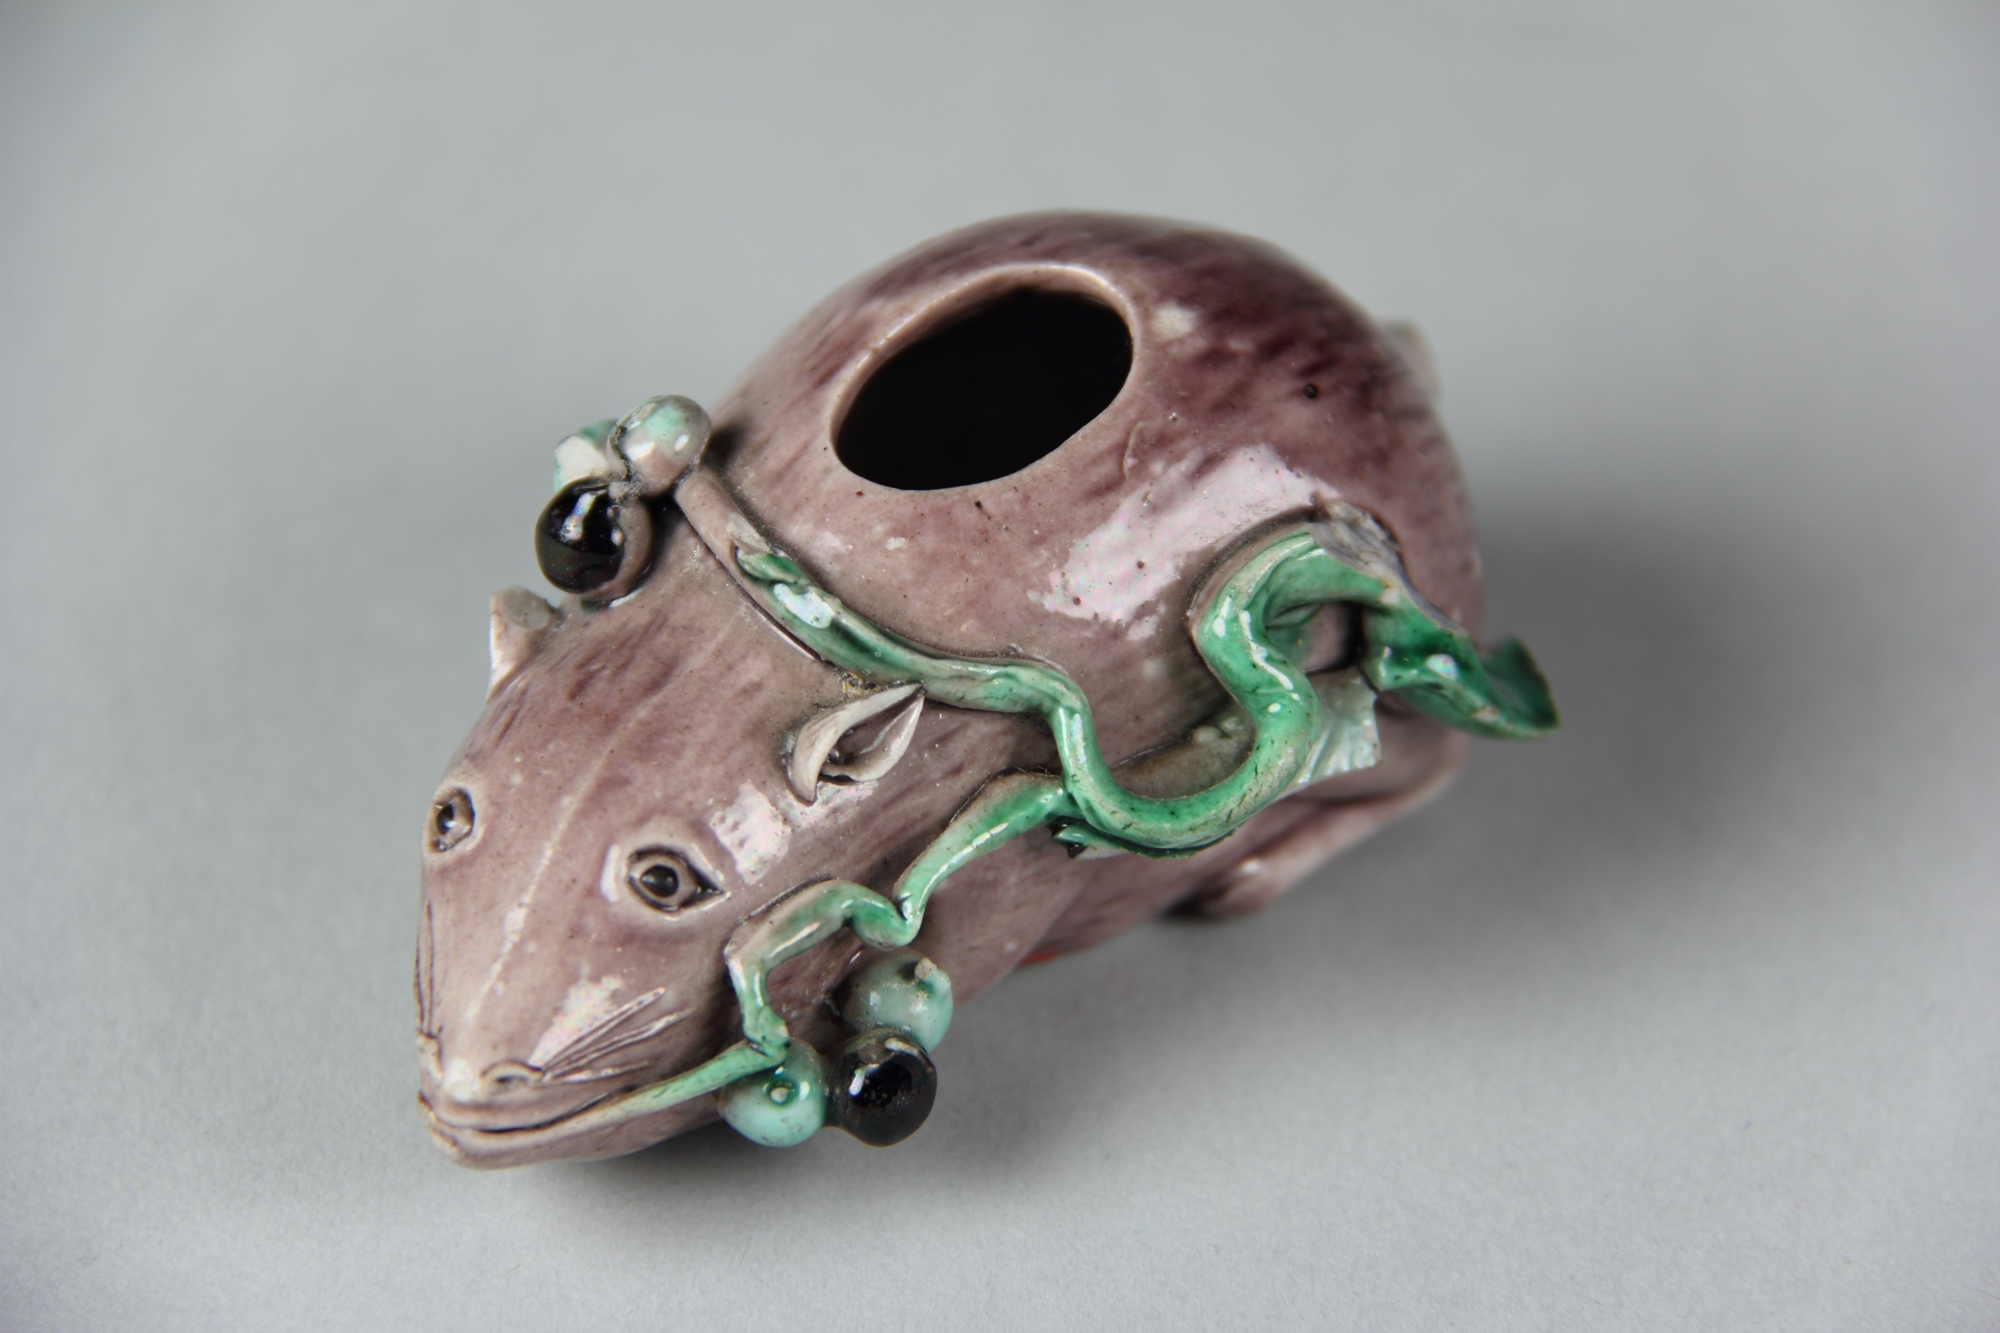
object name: water coupe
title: Water Coupe in the Shape of a Mouse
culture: chinese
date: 1701-1800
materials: biscuit, enamel, porcelain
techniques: painting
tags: mice